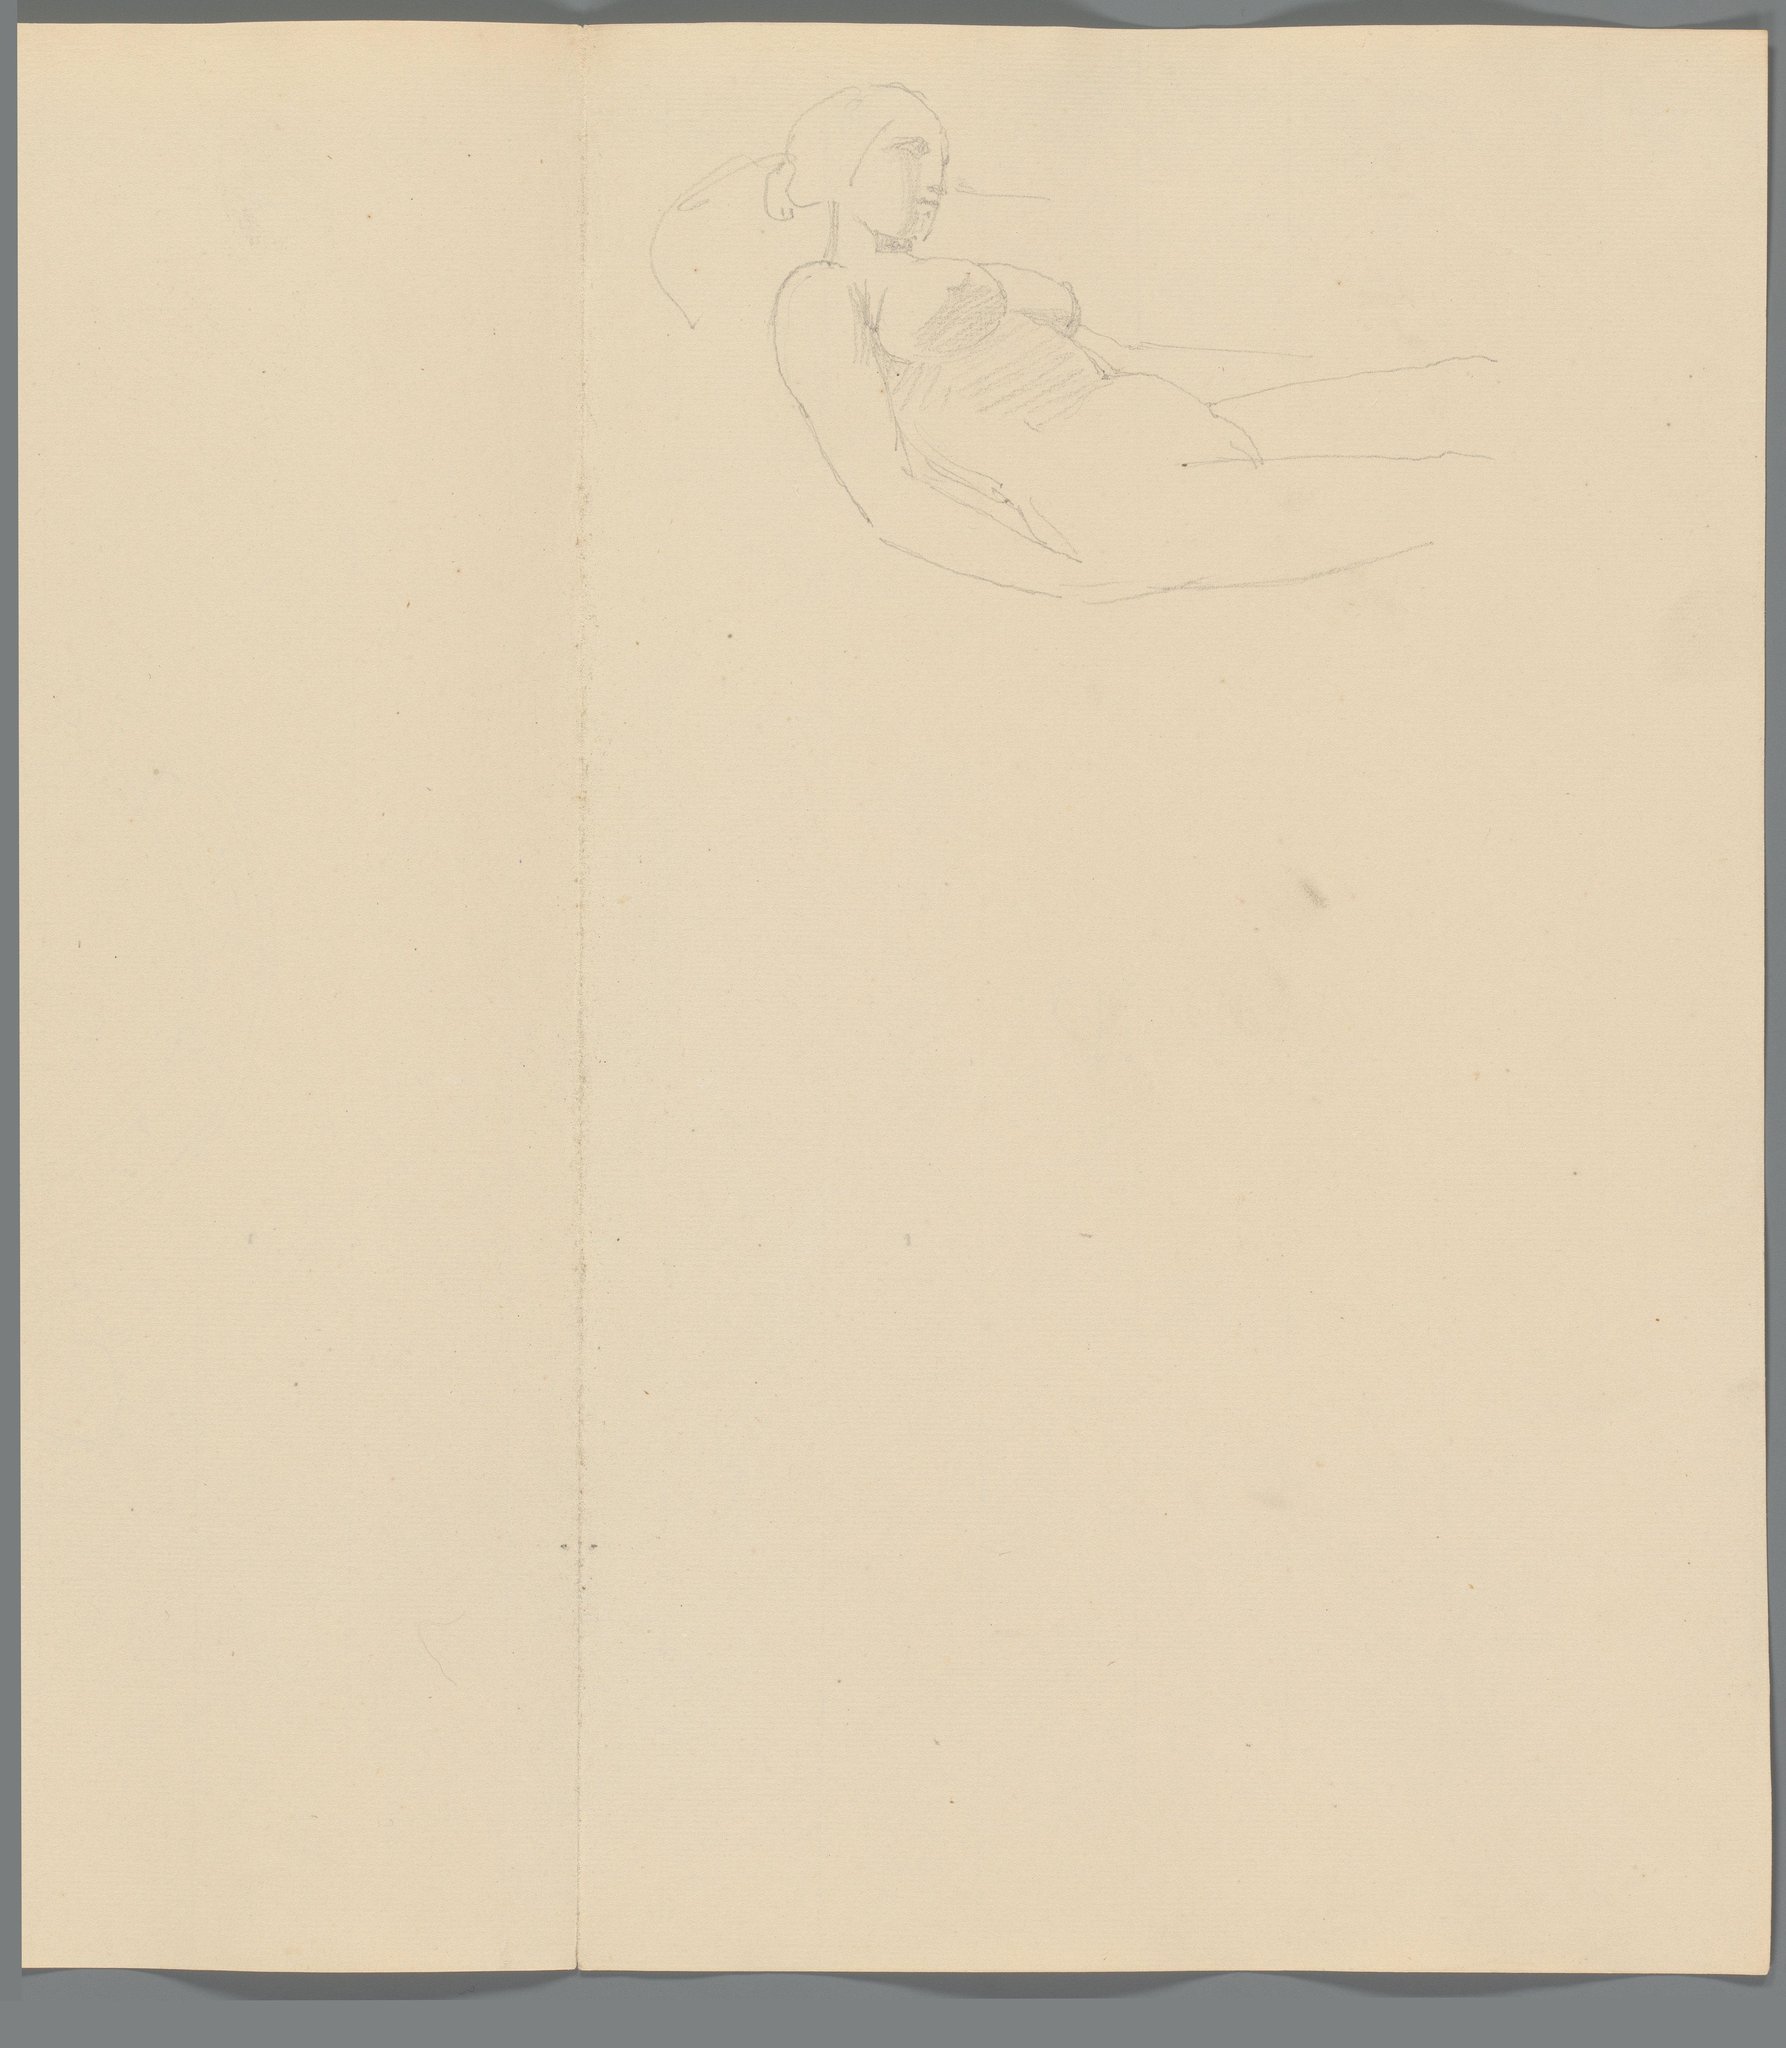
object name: drawing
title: Liggende vrouw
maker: jacobus everhardus josephus van den berg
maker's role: draughtsman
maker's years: 1802-1861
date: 1812-1861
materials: paper, pencil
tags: lying figure - aa - female human figure